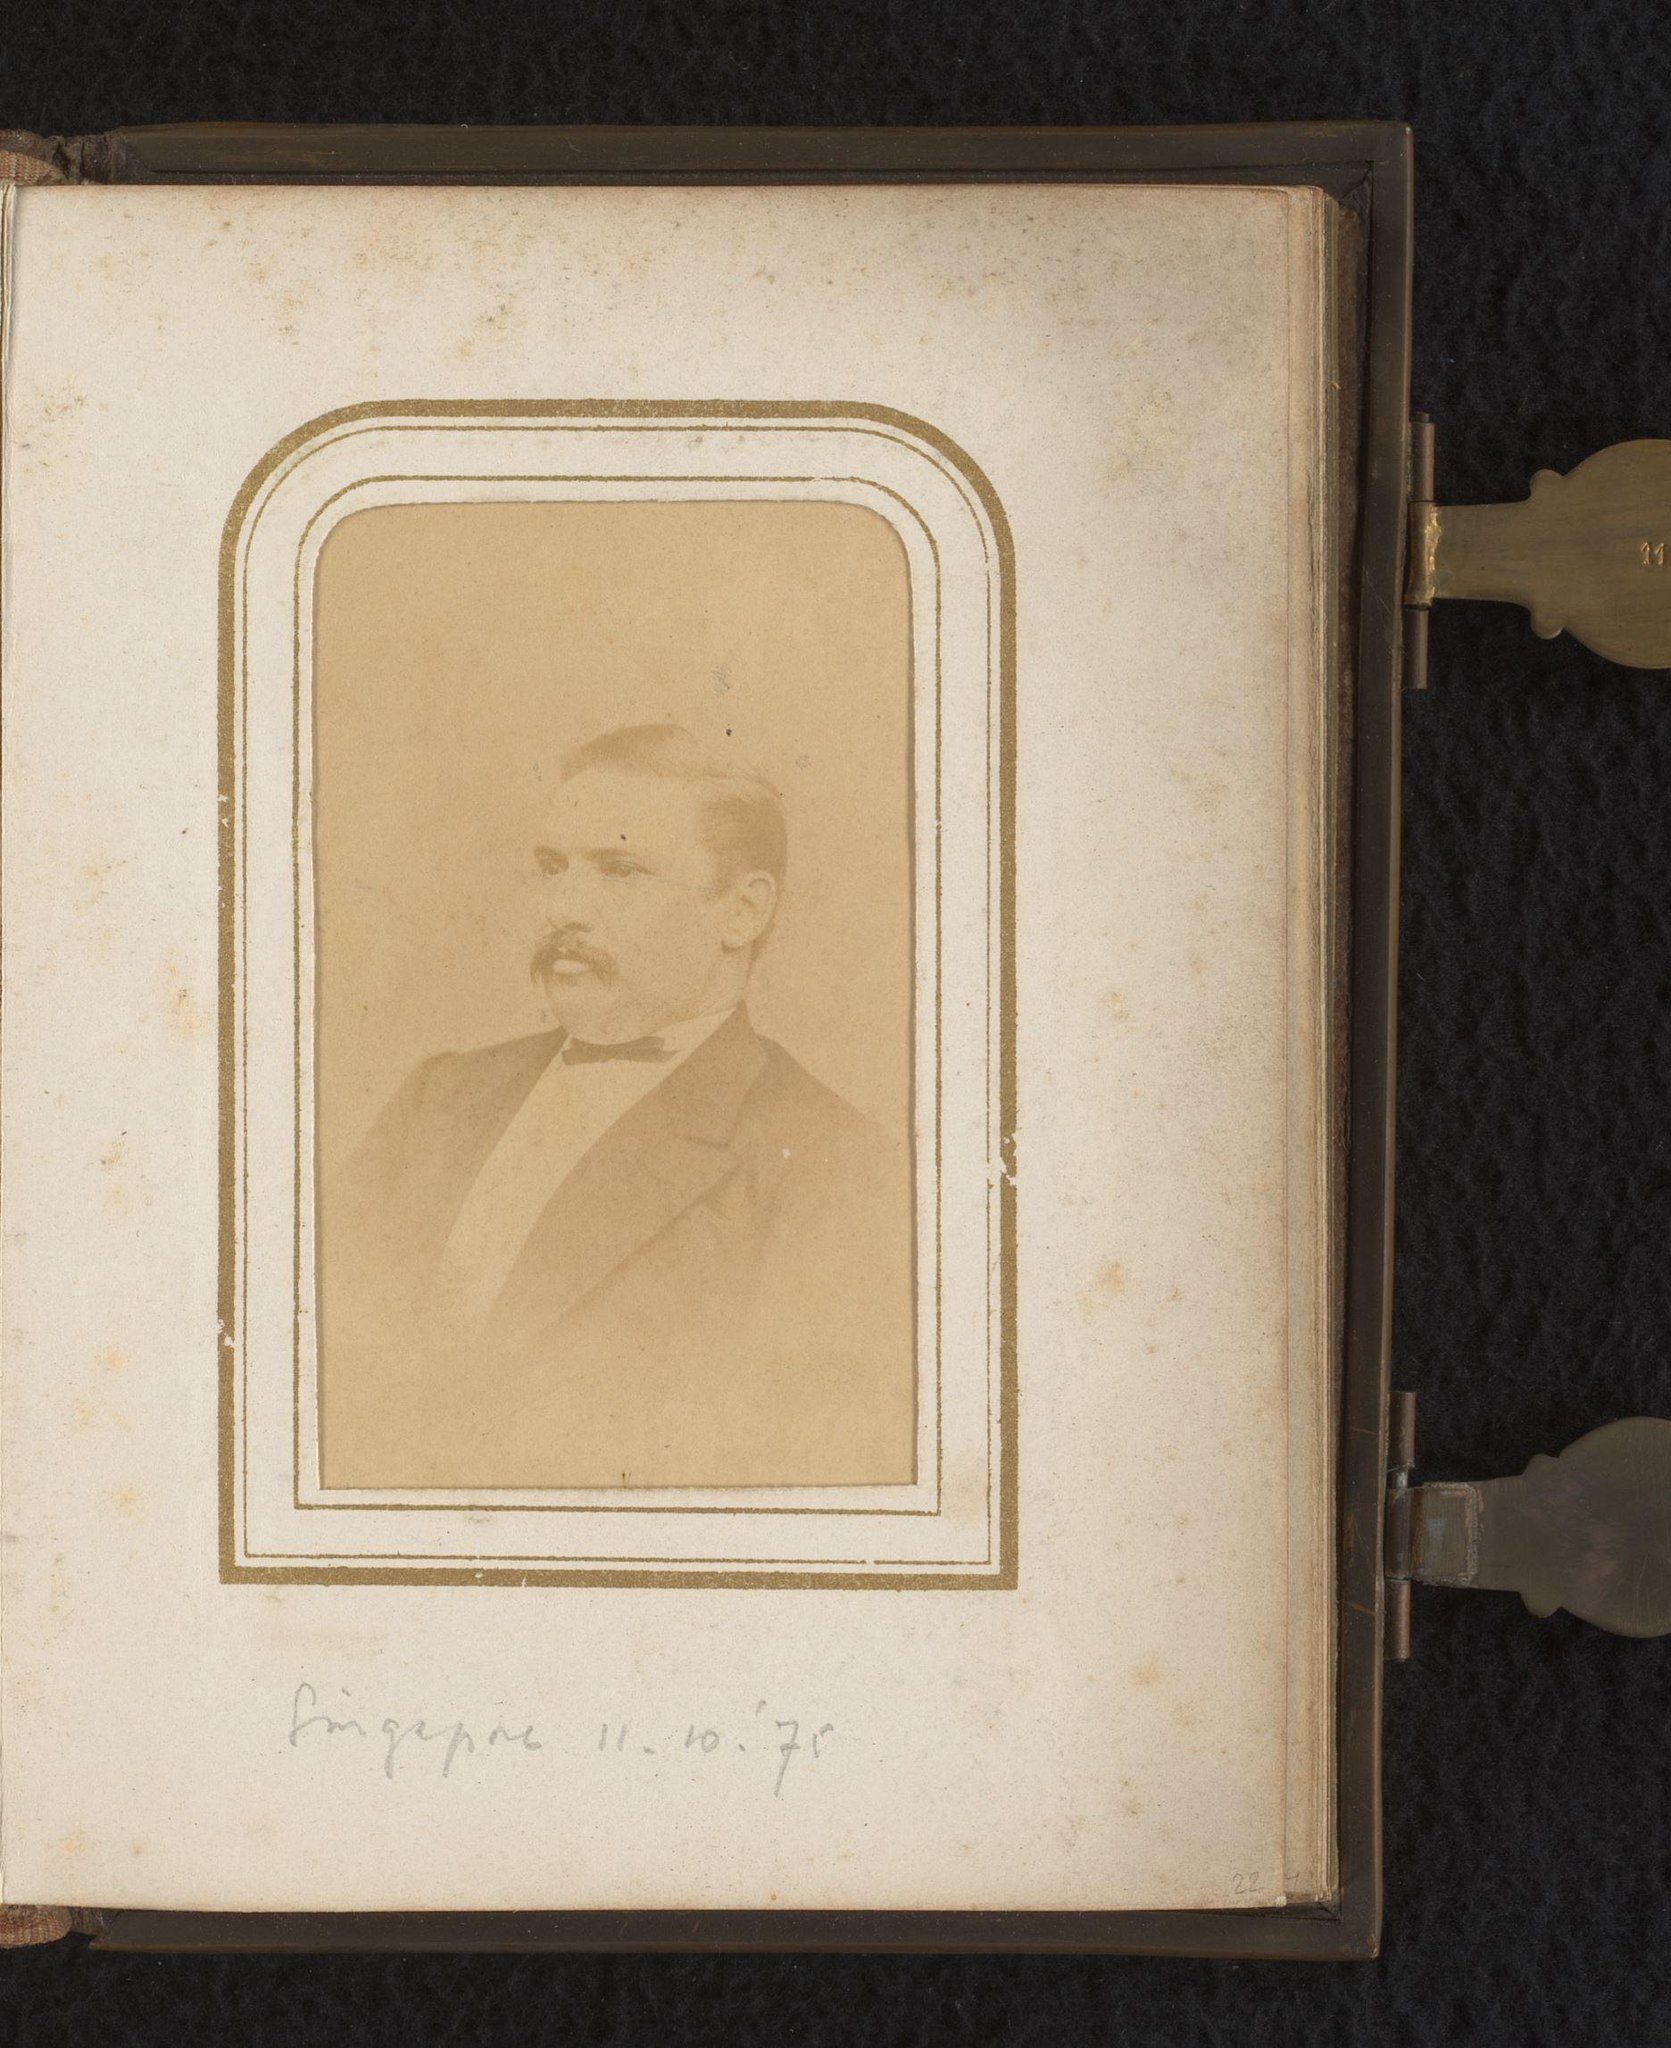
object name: photograph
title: Portret van een man met snor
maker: august sachtler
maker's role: fotograaf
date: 1875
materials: cardboard, photographic support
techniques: albumen print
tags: moustache, adult man, historical persons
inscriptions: annotation: ‘Singapore 11-10-'75’, inscription: ‘A. Sachtler/ Singapore’, annotation: ‘[...]/ 11/10. 75’